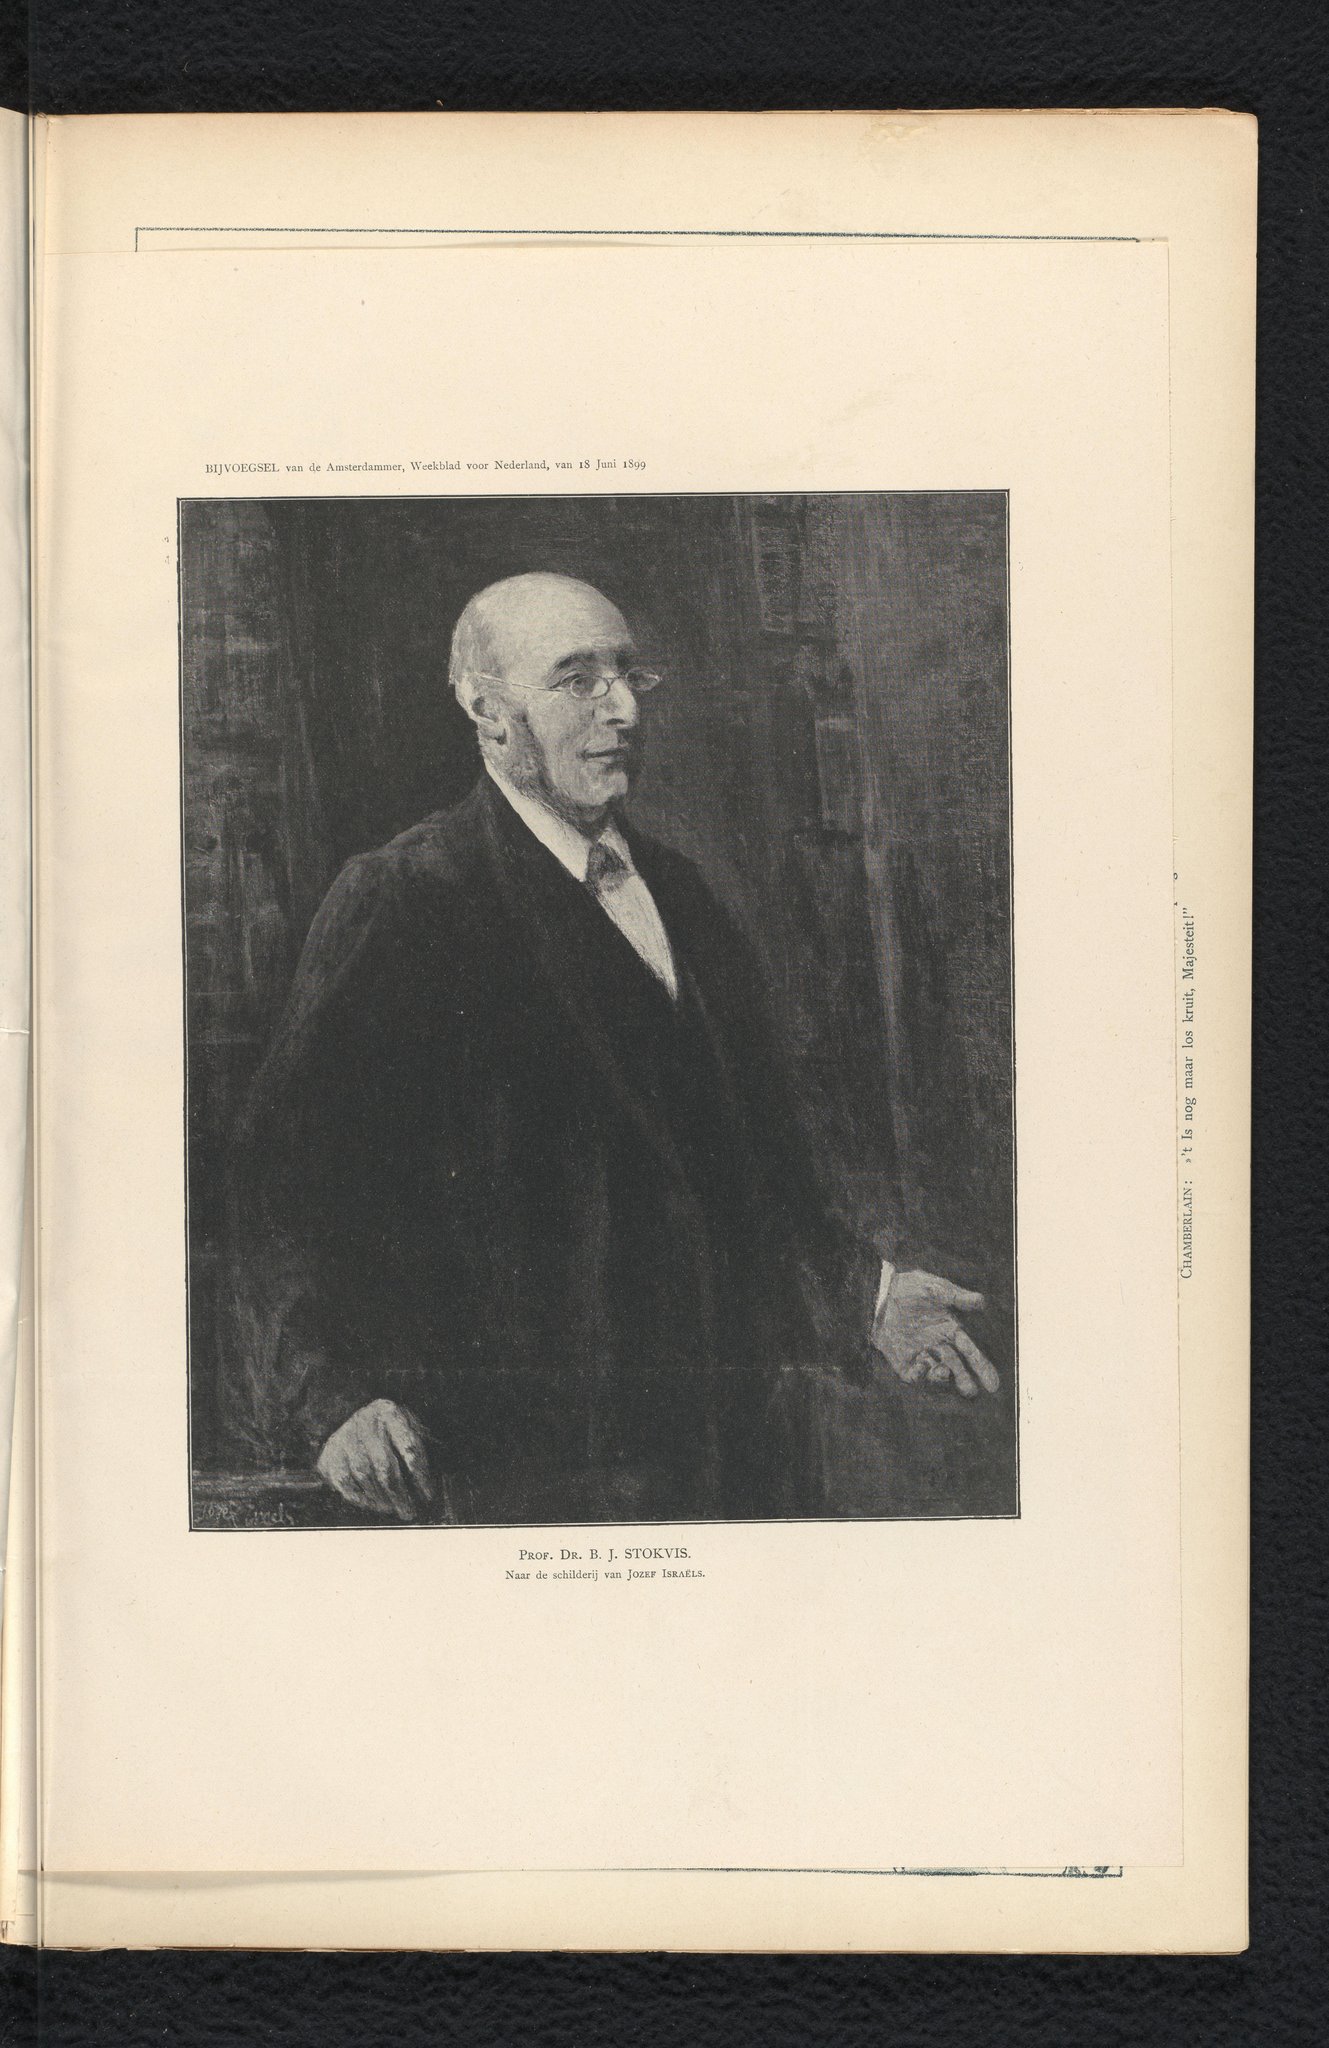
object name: photomechanical print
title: Prof. Dr. B.J. Stokvis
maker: jozef israëls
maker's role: draughtsman, painter, print maker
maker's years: 1824-1911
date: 1899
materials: paper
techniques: autotype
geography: netherlands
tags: amsterdam, barend joseph stokvis, historical persons, professor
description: Gepubliceerd als bijvoegsel bij 'De Amsterdammer' van 18 juni 1899.